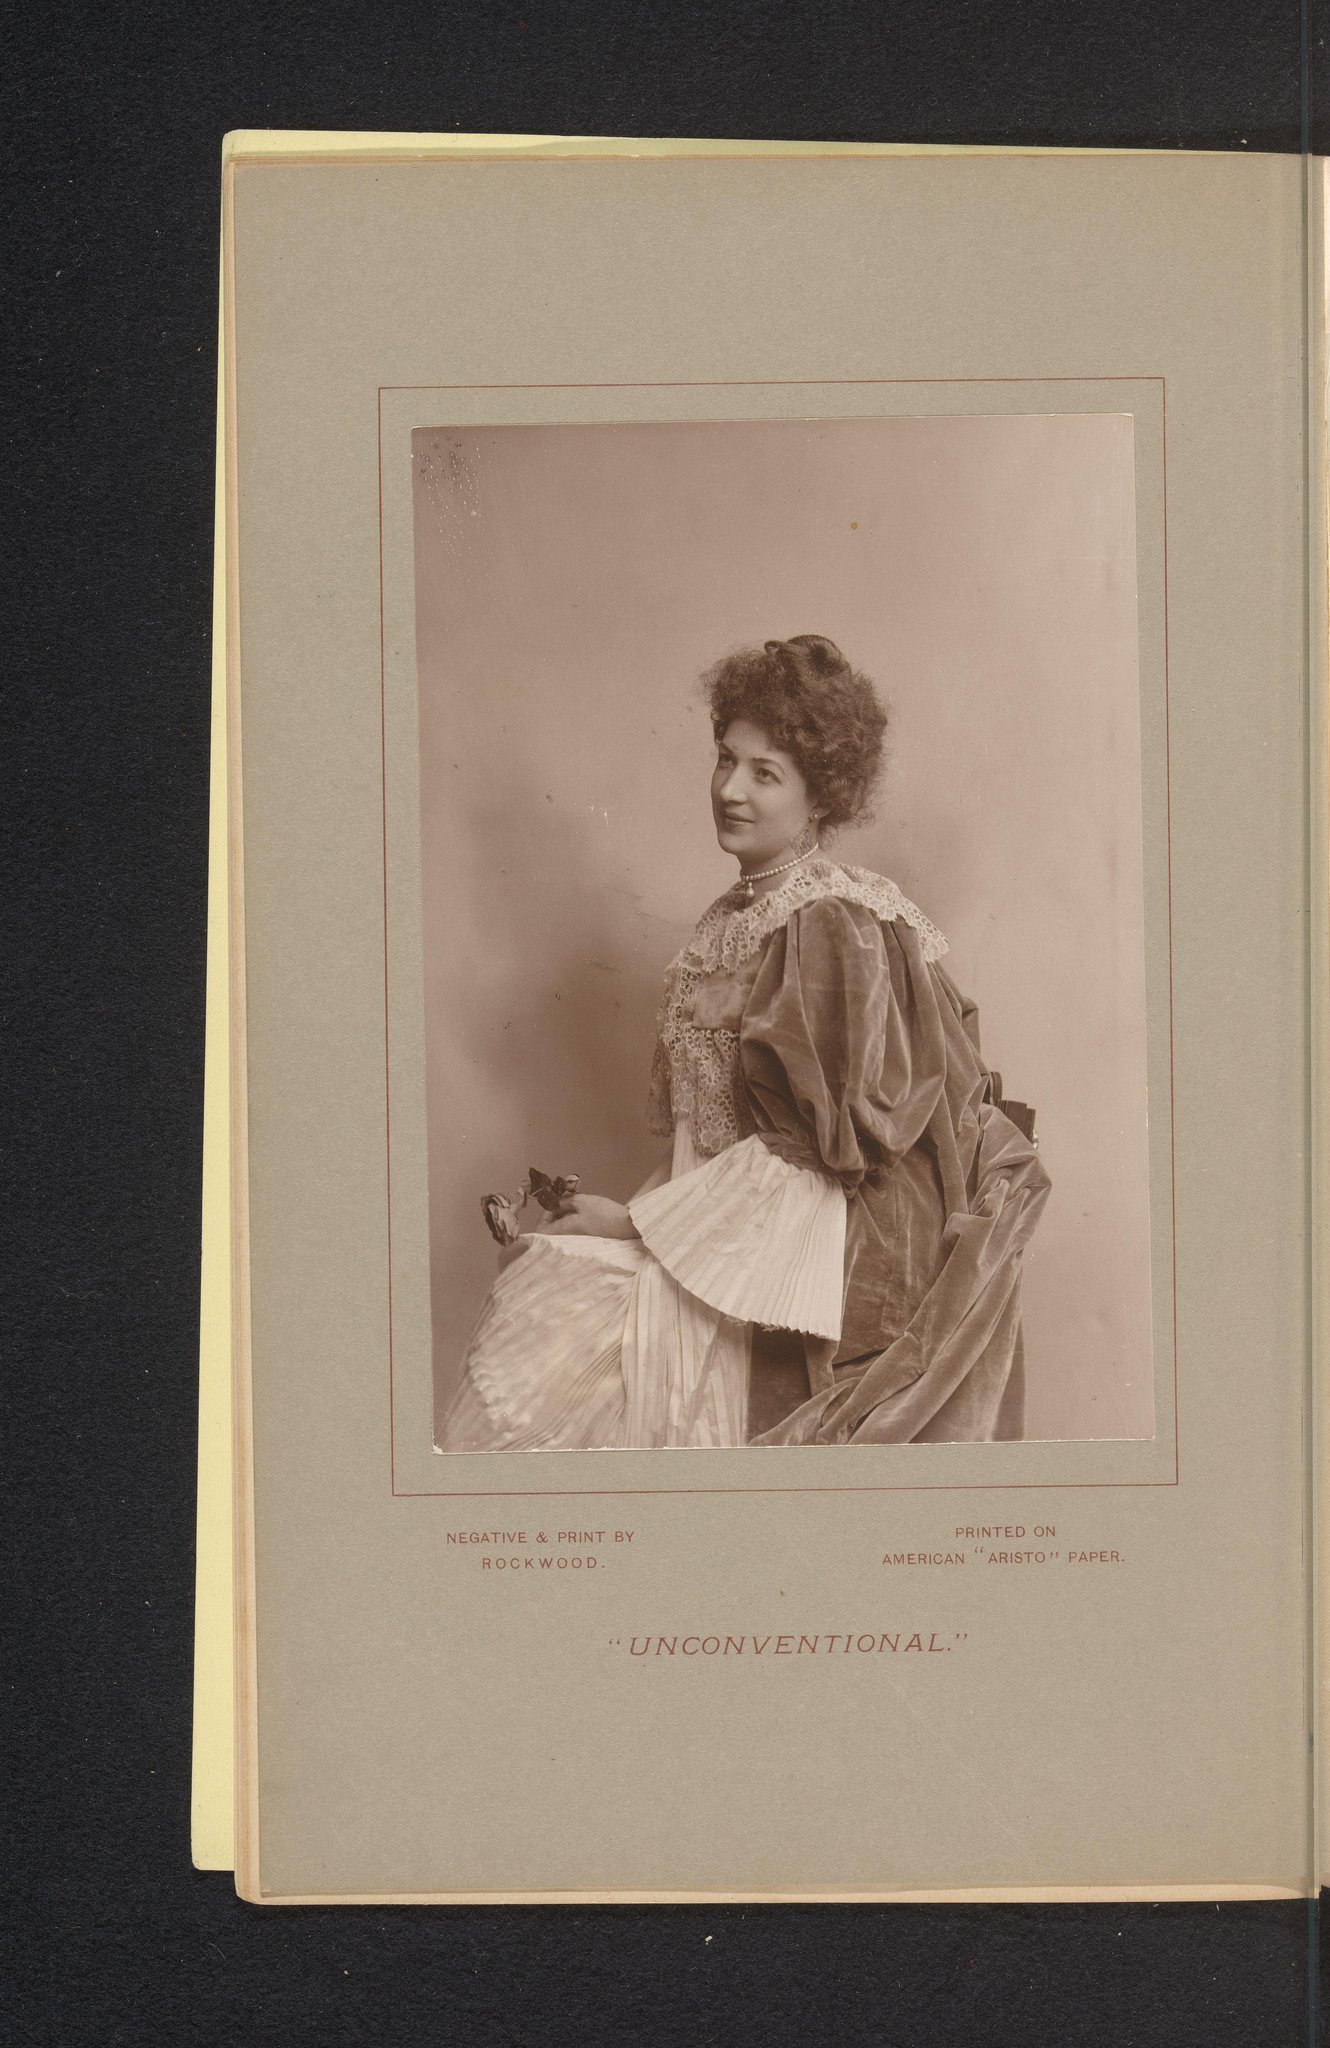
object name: photograph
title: Portret van een onbekende vrouw met een roos in haar hand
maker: rockwood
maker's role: fotograaf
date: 1888-1893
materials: photographic support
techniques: collodion silver print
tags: flowers, adult woman, historical persons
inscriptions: inscription: ‘Printed on American "Aristo" paper’